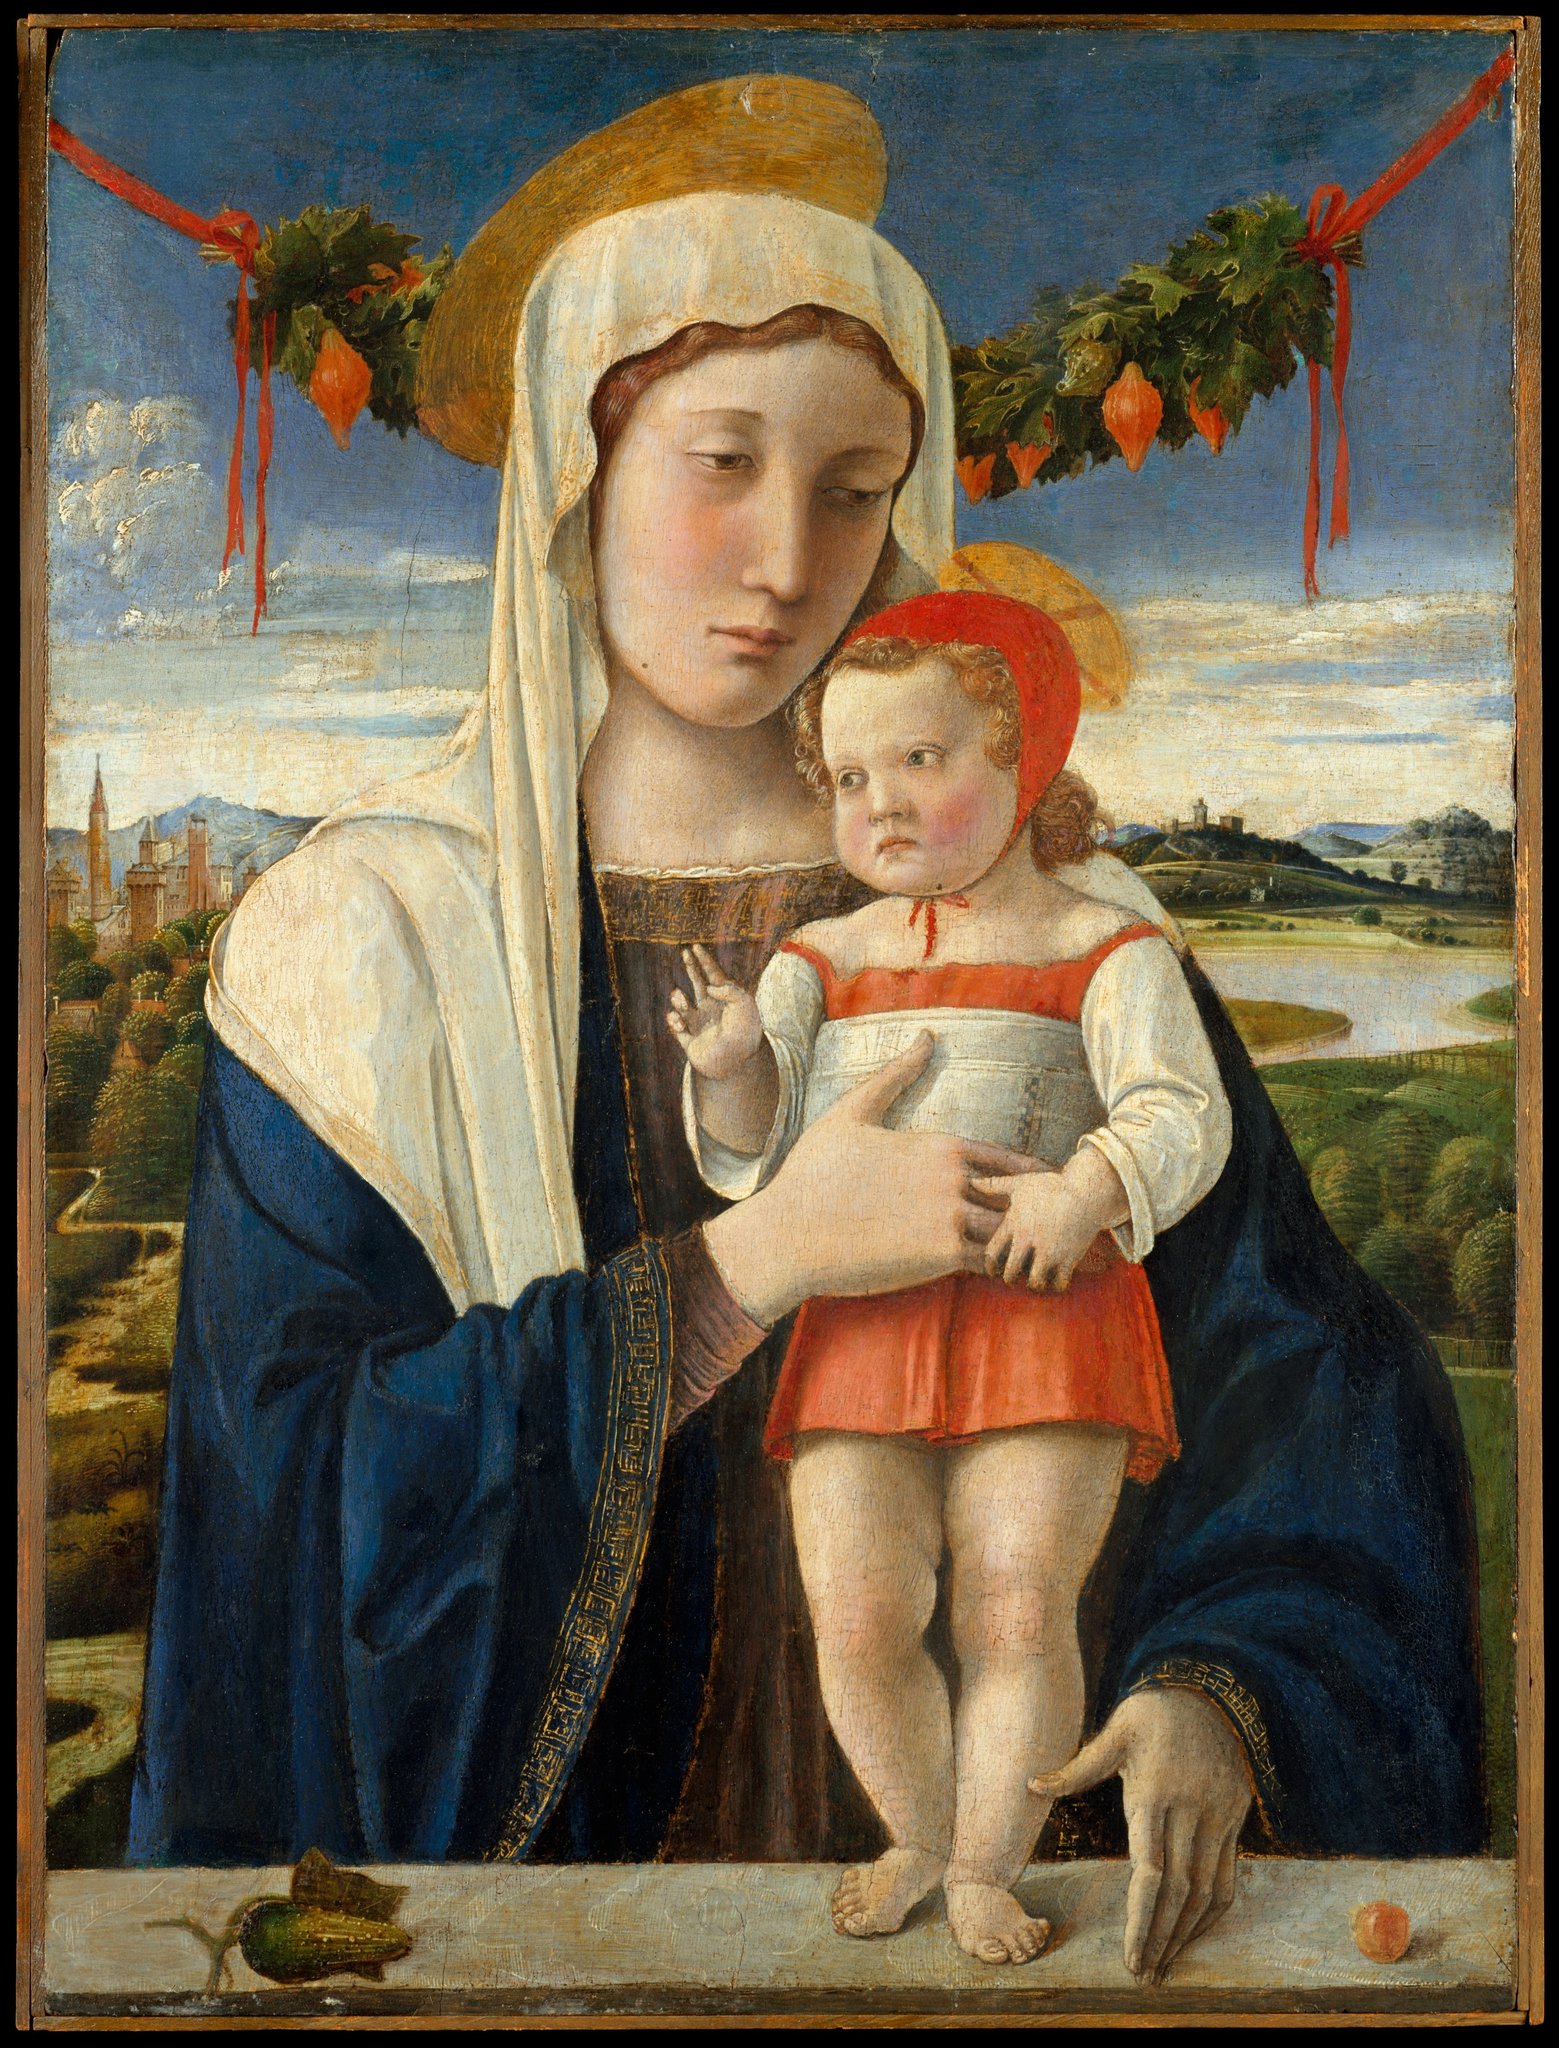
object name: painting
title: Madonna and Child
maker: giovanni bellini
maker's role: artist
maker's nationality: italian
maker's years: 1424-1516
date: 1470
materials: gold, oil, paint, wood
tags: madonna and child